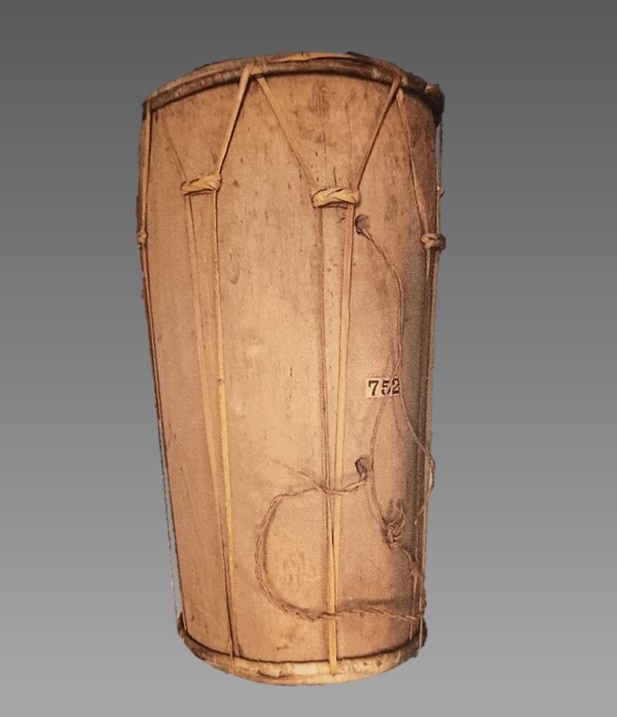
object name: ketipung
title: Ketipung (drum)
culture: javanese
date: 1867-1900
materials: fiber, skin, wood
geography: indonesia